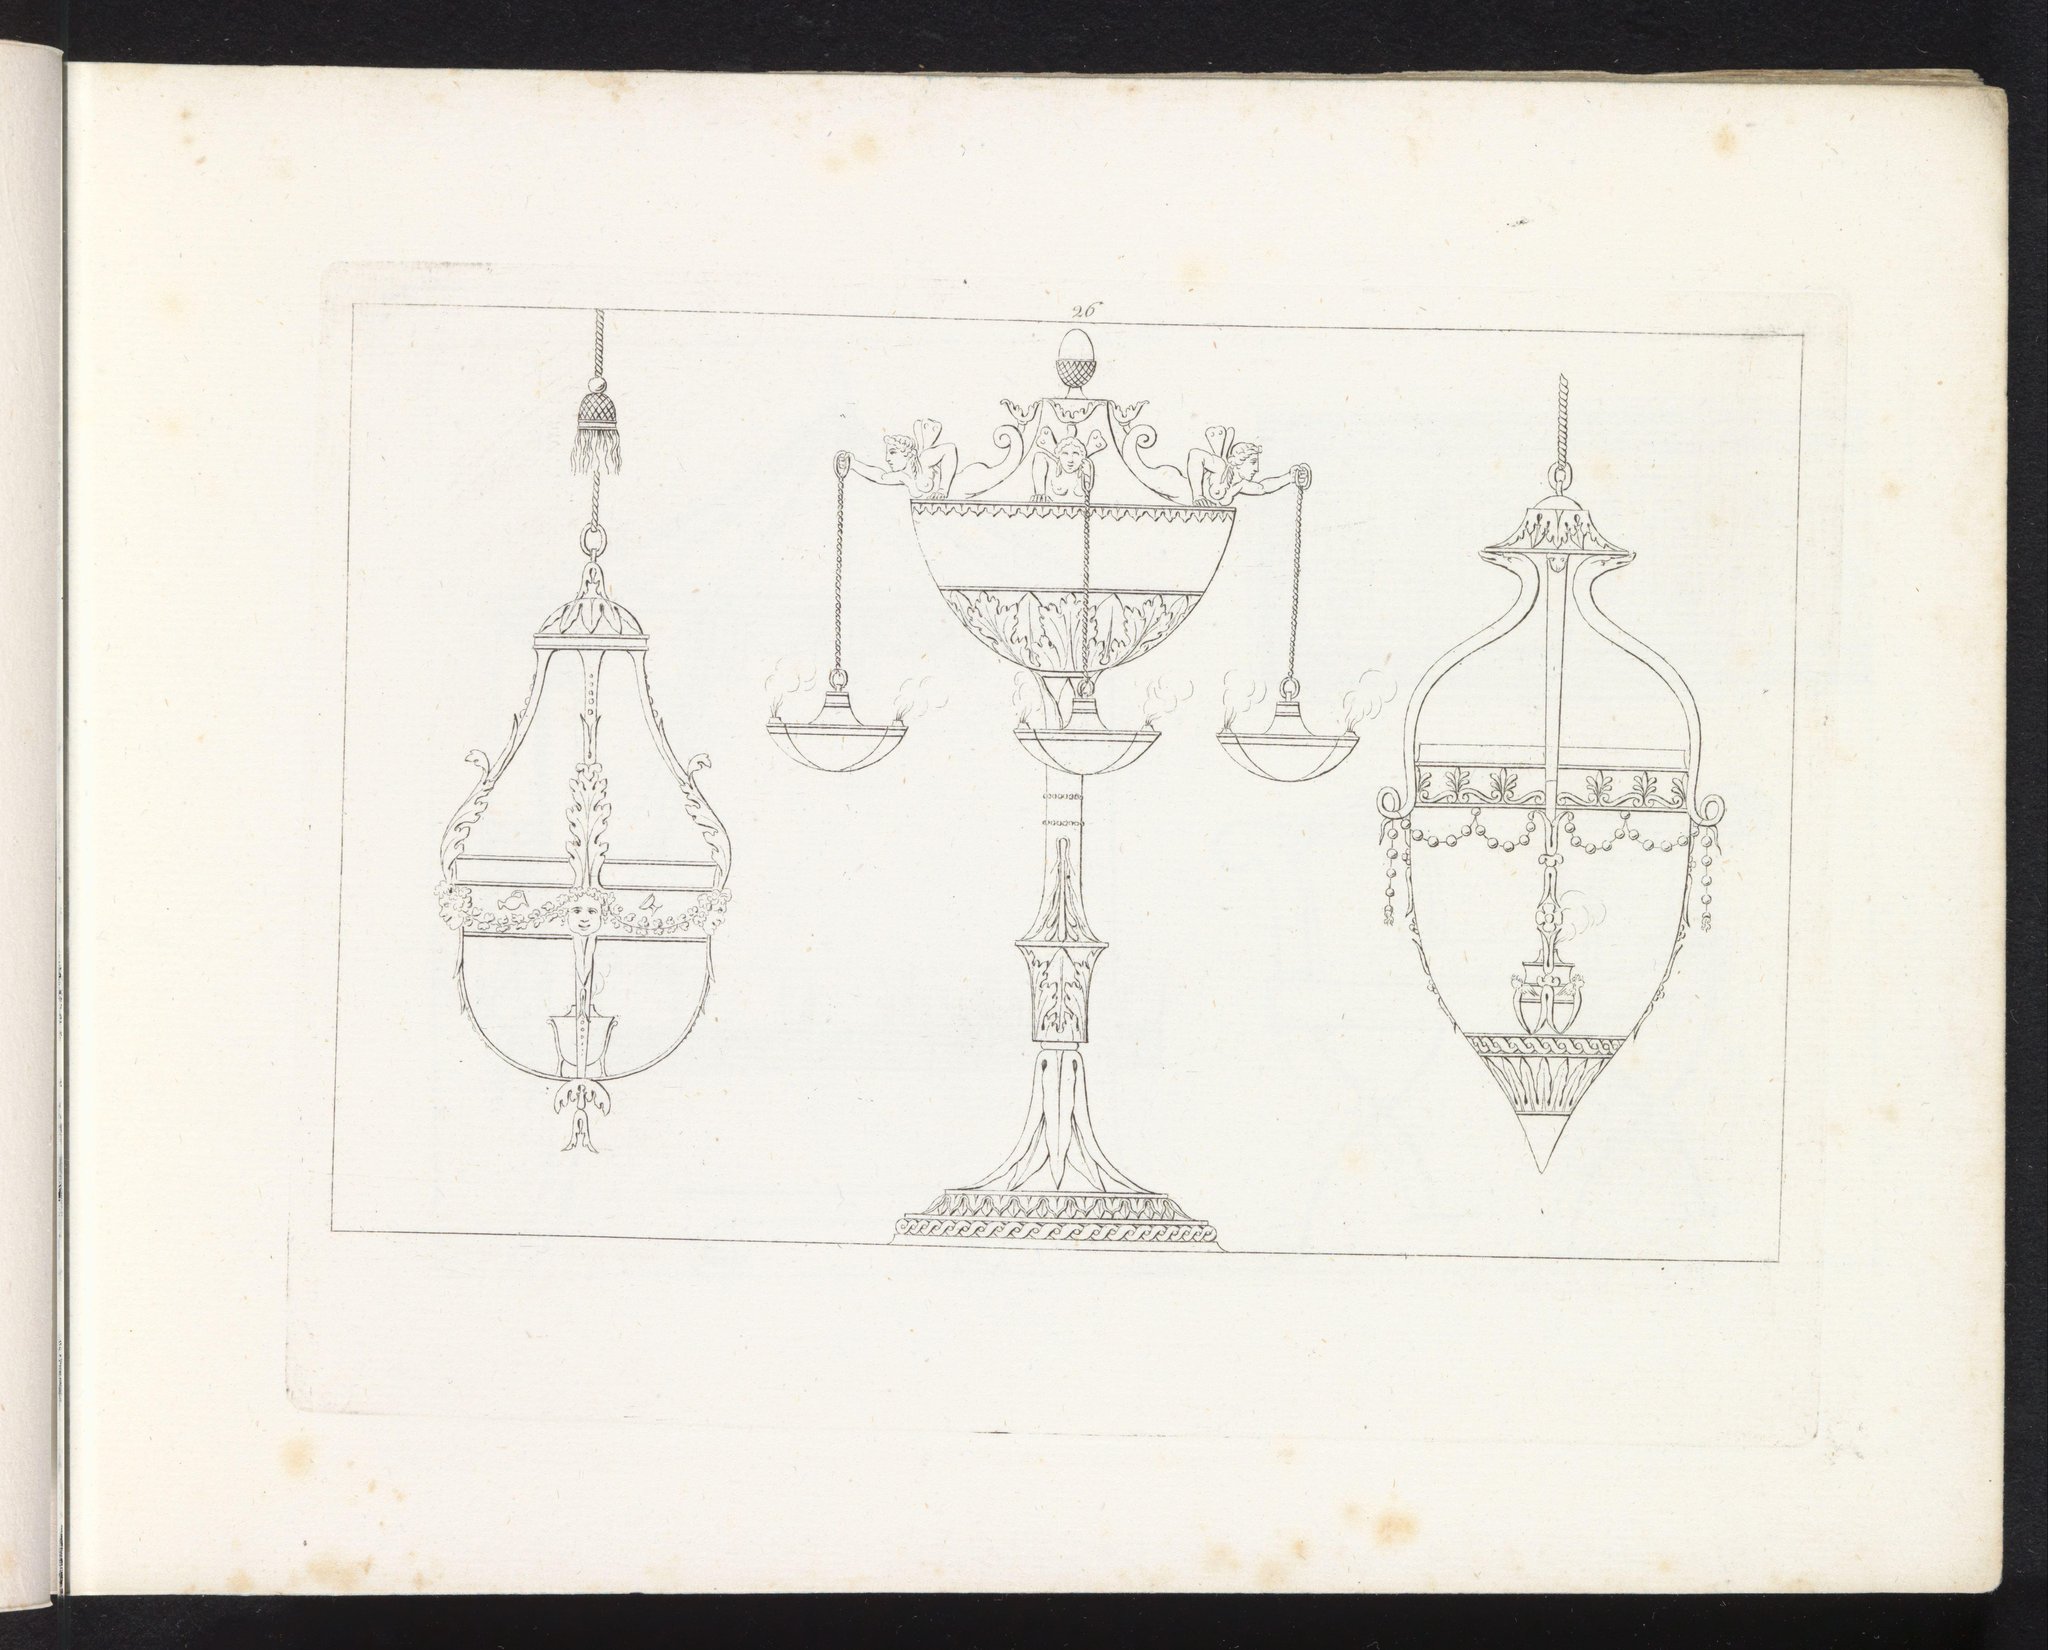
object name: album leaf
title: Invenzioni diverse di mobili ed utensili sacri e profani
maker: pietro ruga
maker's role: print maker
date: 1817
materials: paper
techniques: etching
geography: milan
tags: ornaments ~ art, censer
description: Prent maakt deel uit van een reeks van 100 prenten (+ titelprent) met ontwerpen voor religieuze en profane voorwerpen.